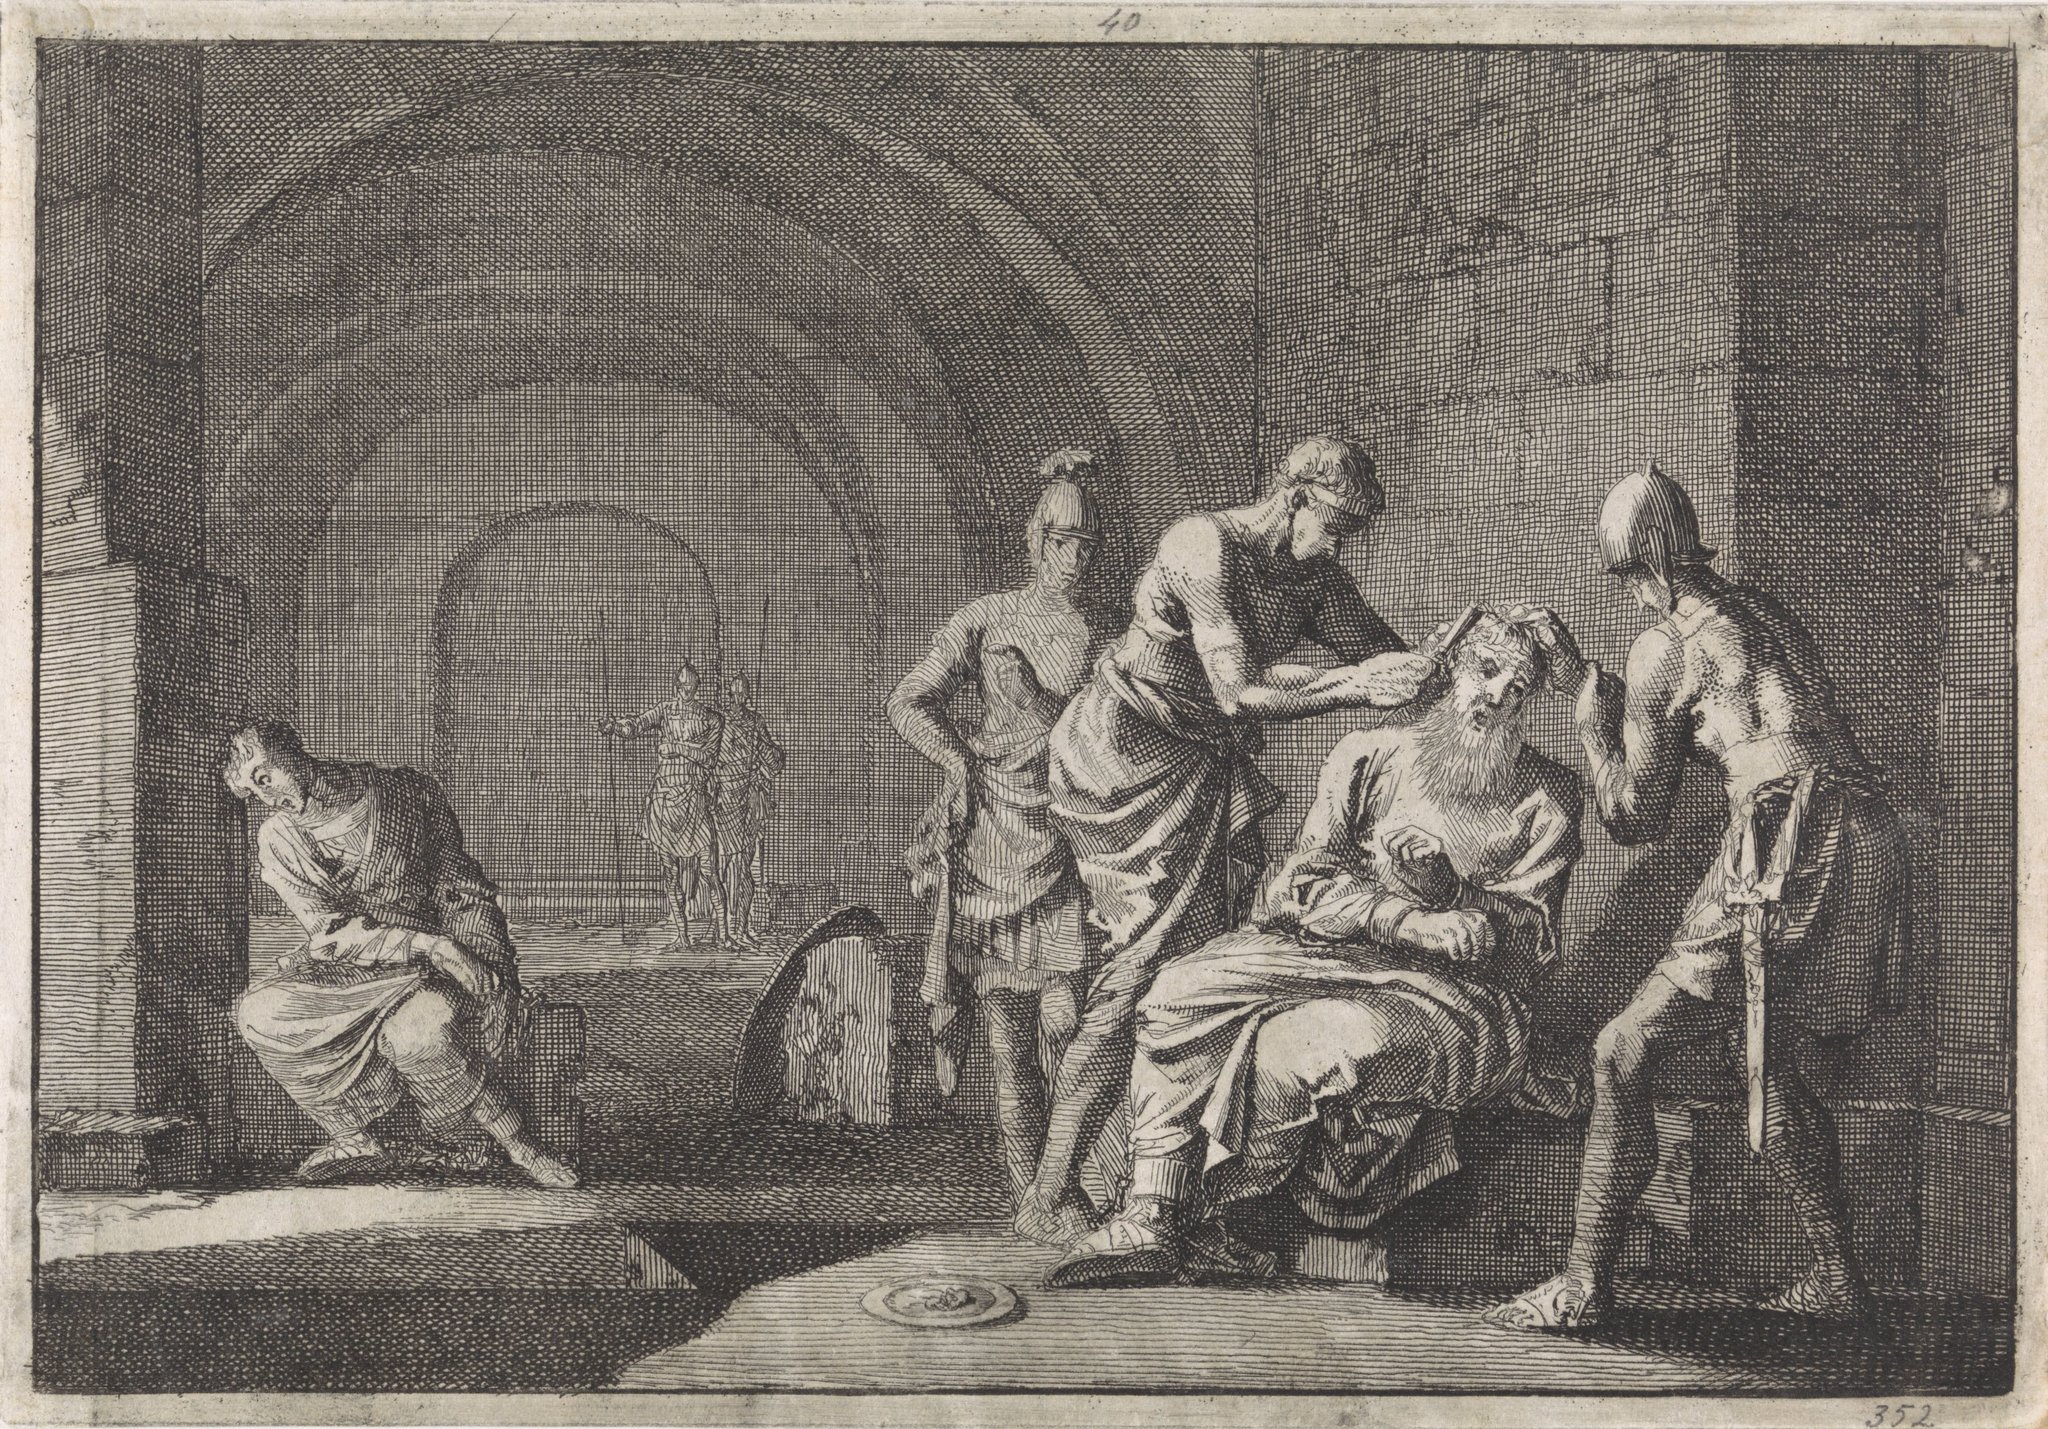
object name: print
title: Hyrkanus de oren afgesneden in de gevangenis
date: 1704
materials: paper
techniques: etching, letterpress printing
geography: amsterdam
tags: prison, jail, violent death by removal of parts of the body by cutting, sawing, tearing - ee - death not certain; wounded person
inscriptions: collector's mark: Lugt 2228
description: Prent opgenomen in: Josephus, Flavius. Alle de Werken, 2 delen. Amsterdam: Pieter Mortier, 1704, dl. 1, p. 352.